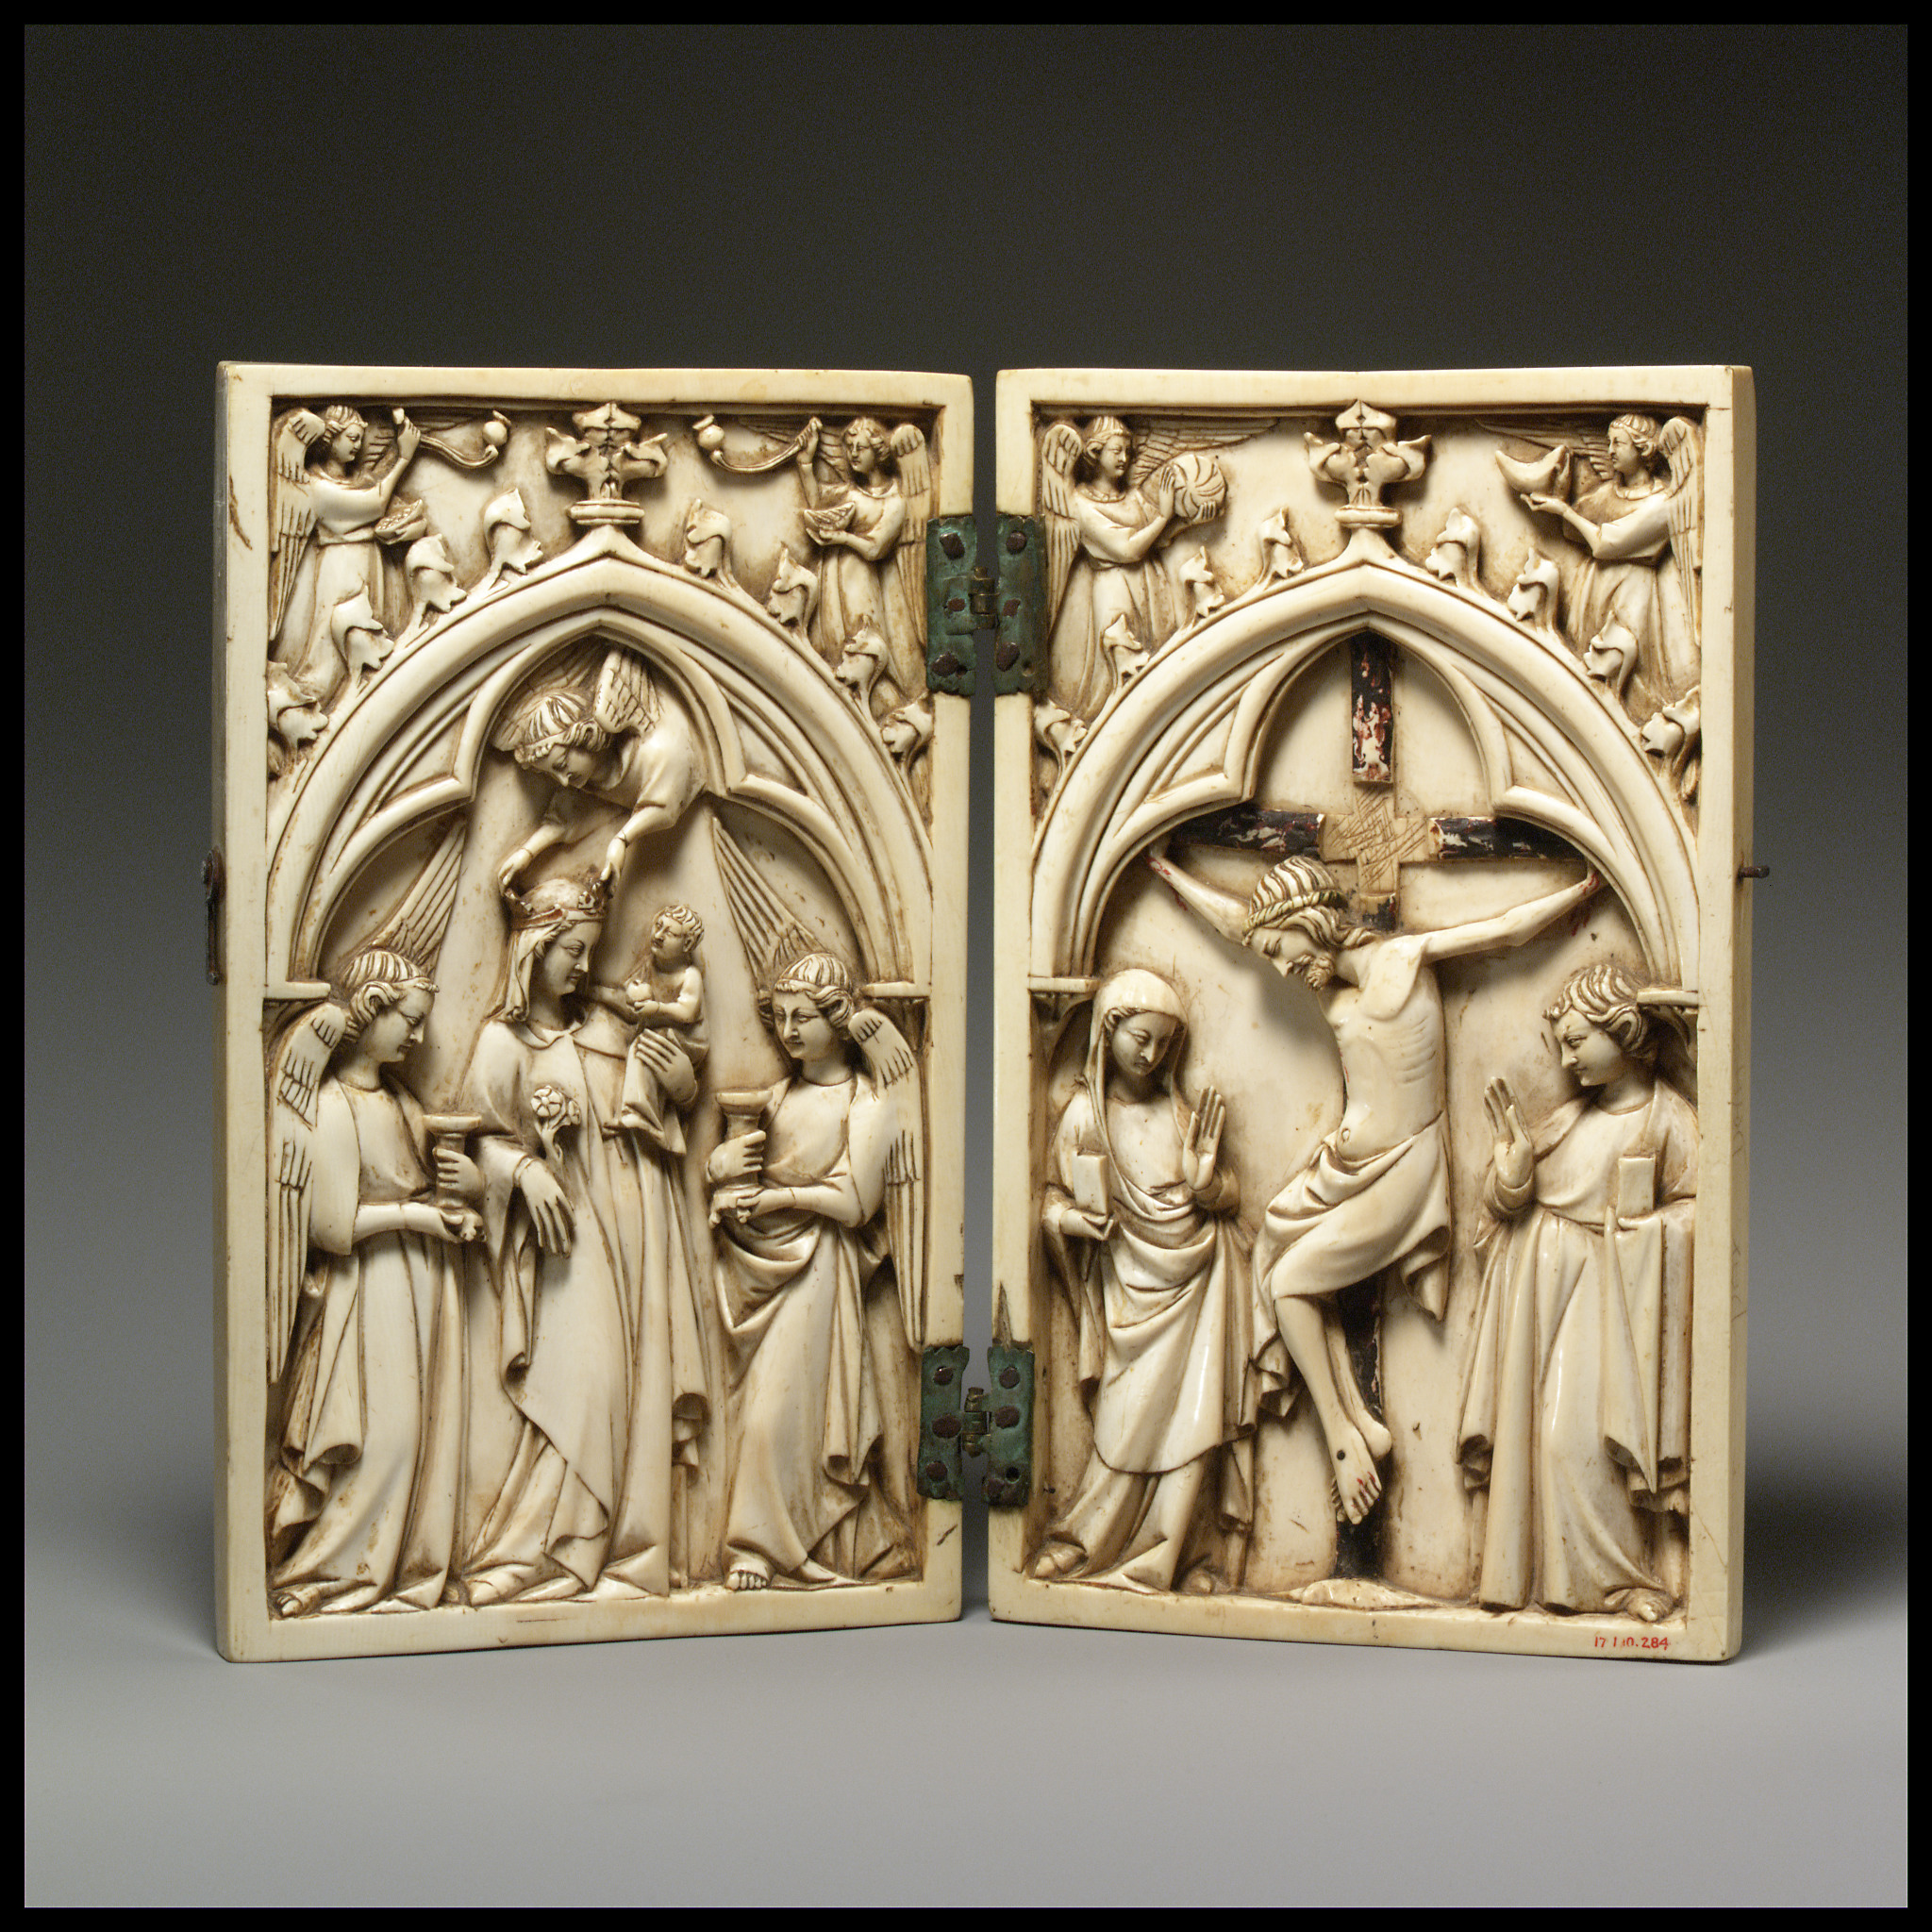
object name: diptych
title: Diptych with Virgin and Child and Crucifixion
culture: french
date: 1301-1400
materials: ivory, metal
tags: angels,christ,madonna and child,crucifixion